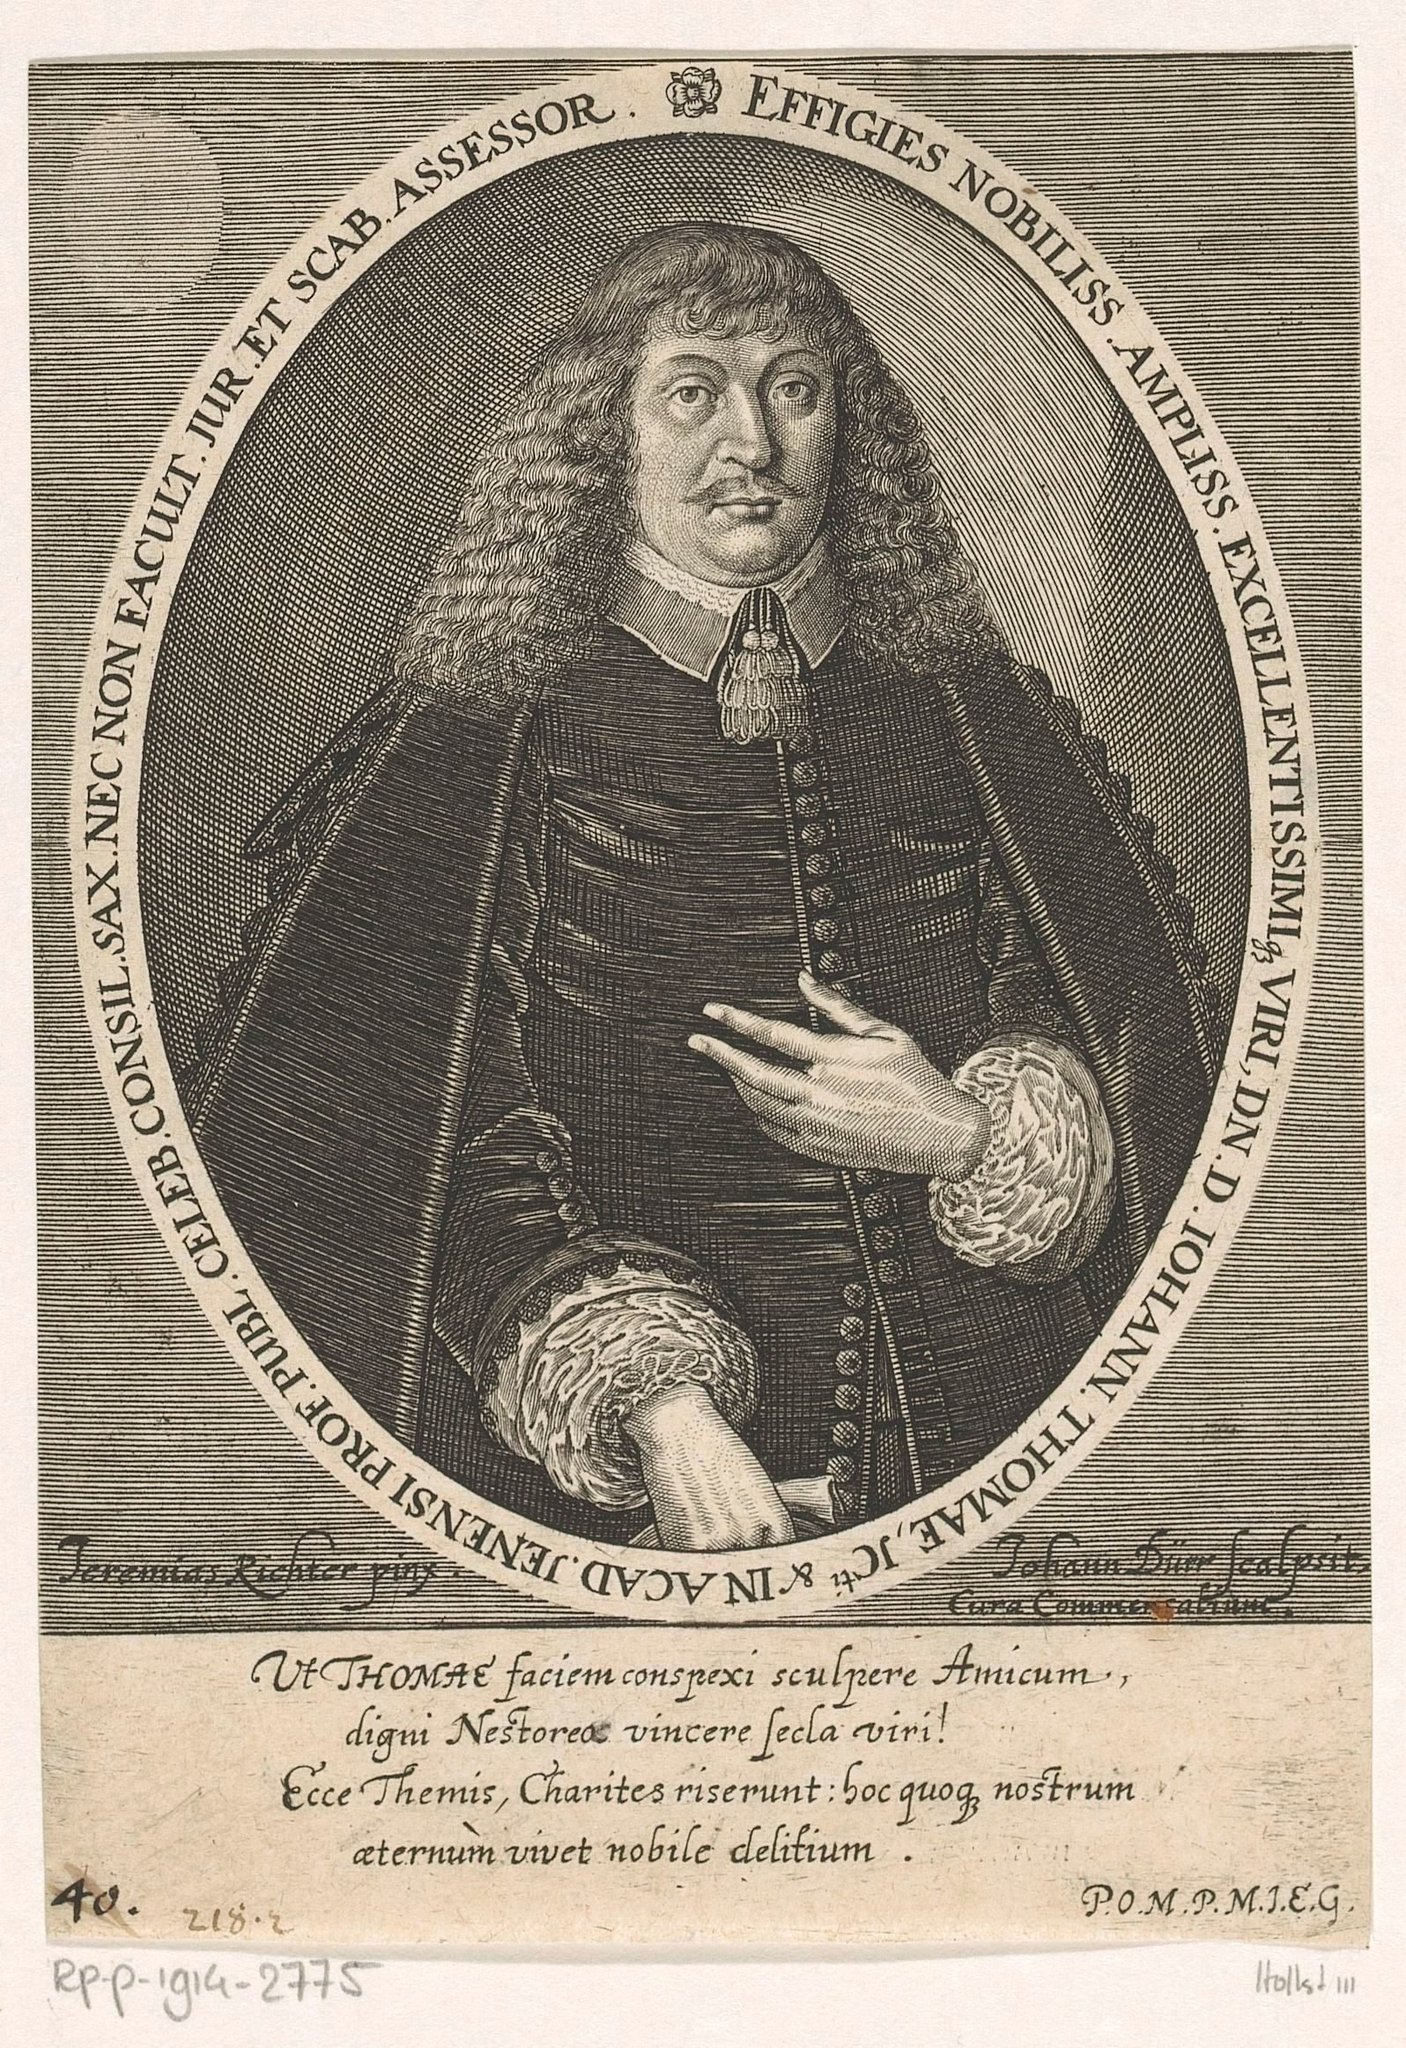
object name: print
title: Portret van Johannes Thomae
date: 1634-1663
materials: paper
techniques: engraving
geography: germany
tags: historical persons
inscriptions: collector's mark: Lugt 2228